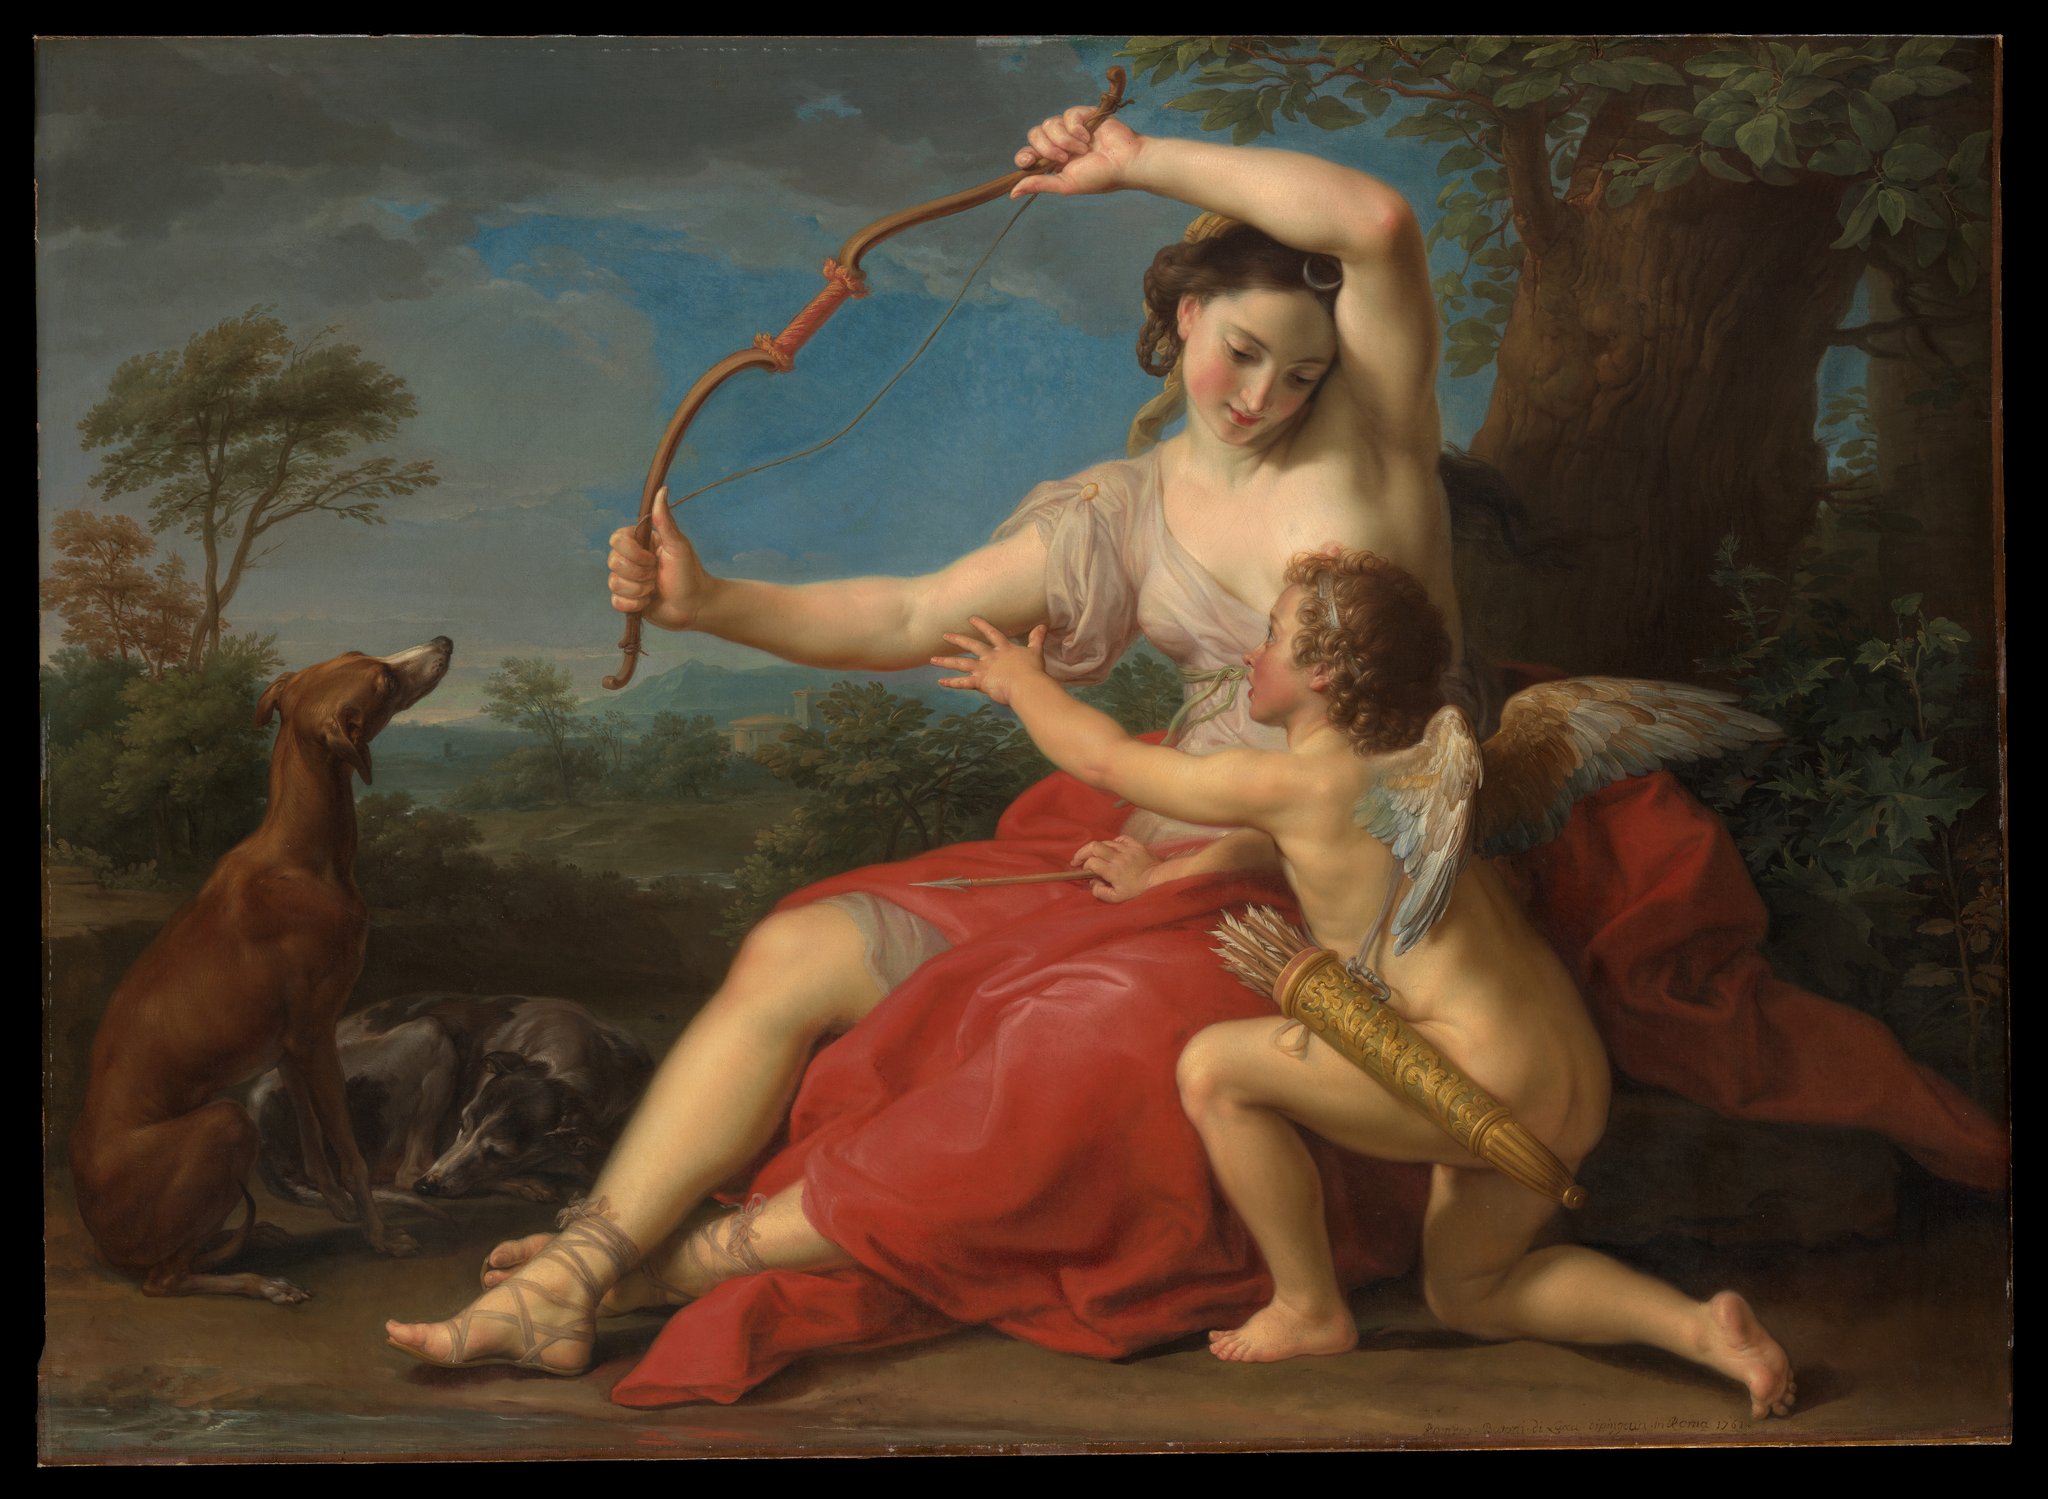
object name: painting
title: Diana and Cupid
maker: pompeo batoni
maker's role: artist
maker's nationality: italian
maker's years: 1708-1787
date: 1761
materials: canvas, oil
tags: bow and arrow,cupid,diana,dogs